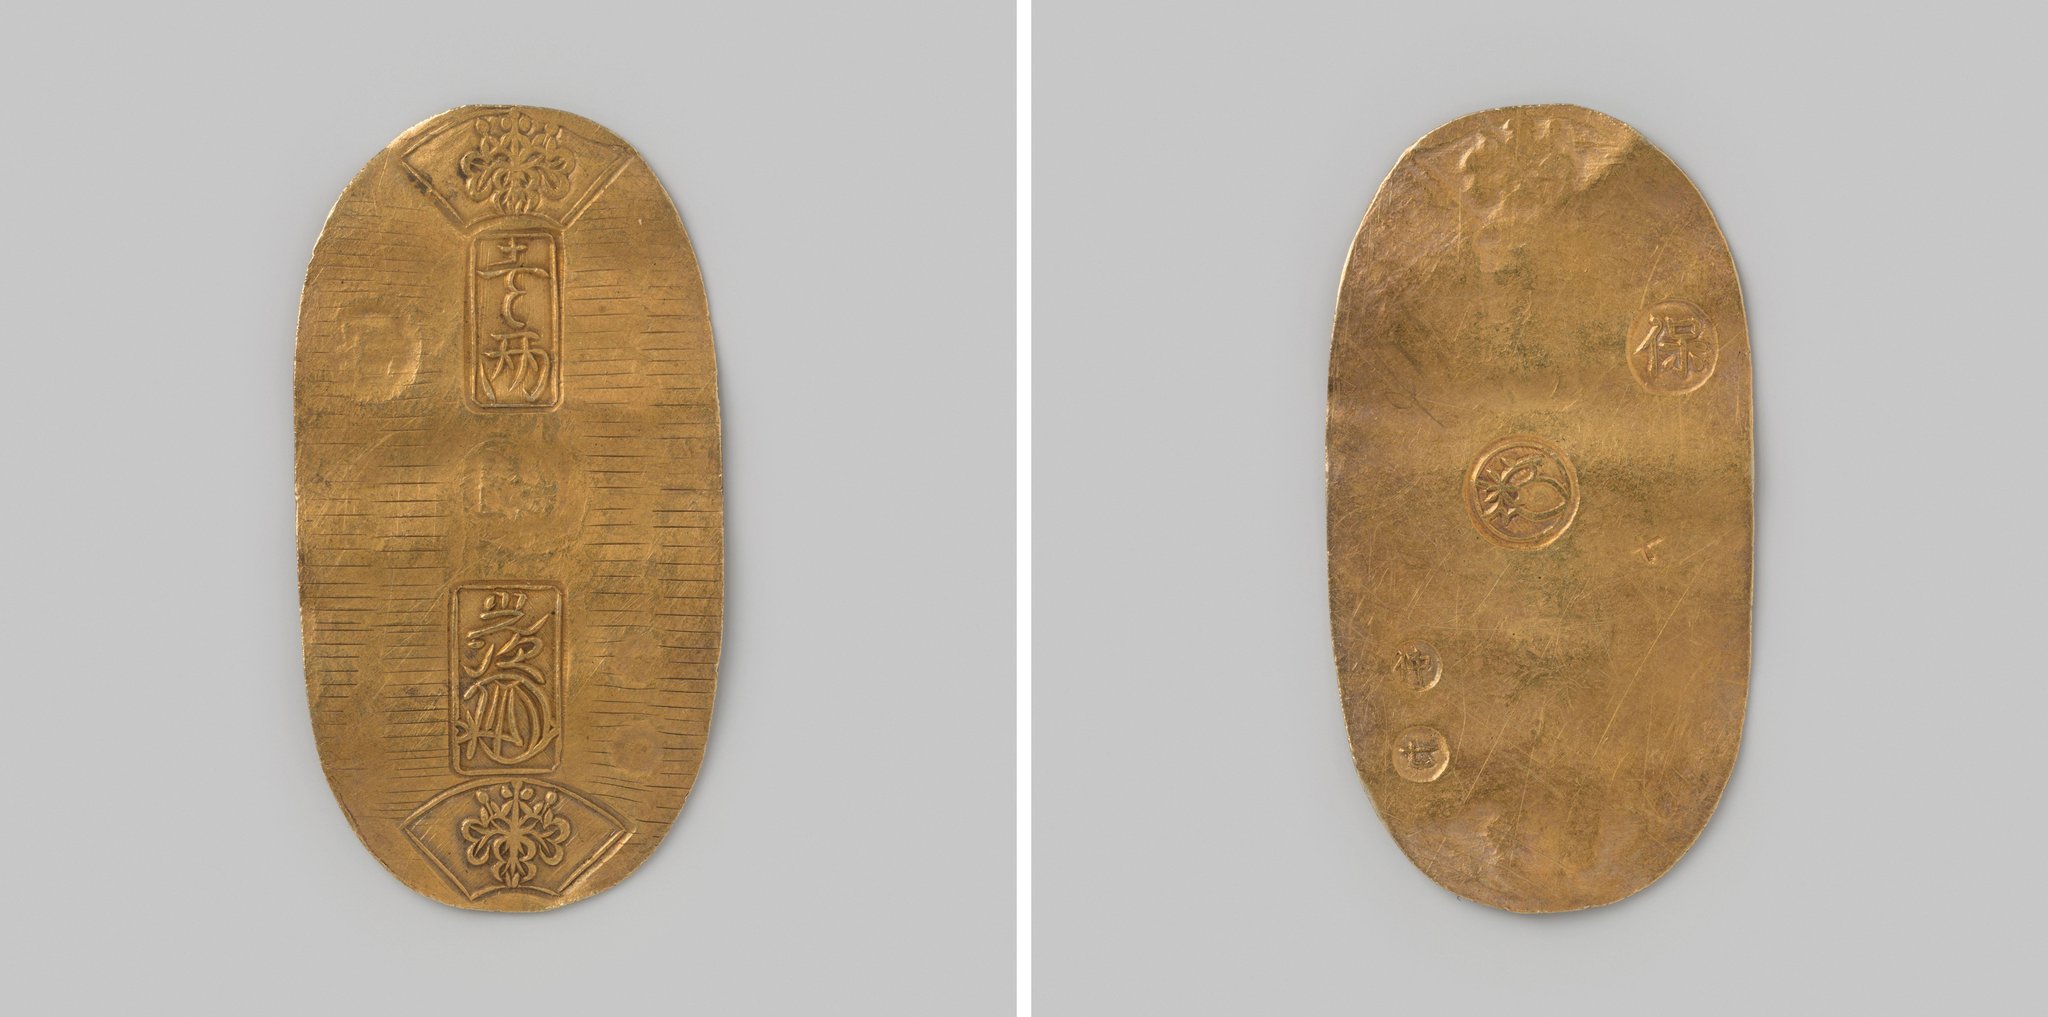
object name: koban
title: Nieuwe gouden koban van het keizerrijk Japan van keizer Nin Kau uit het Tenpo tijdperk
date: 1837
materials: gold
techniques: striking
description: Gouden langwerpige munt met afgeronde hoeken. Voorzijde: aan uiteinden boven en onderaan een bloemmotief, naar elkaar toegewend, waartussen in twee rechthoeken tekens. Keerzijde: vier tekens, waaronder aanduiding van de muntplaats: Kyoto.